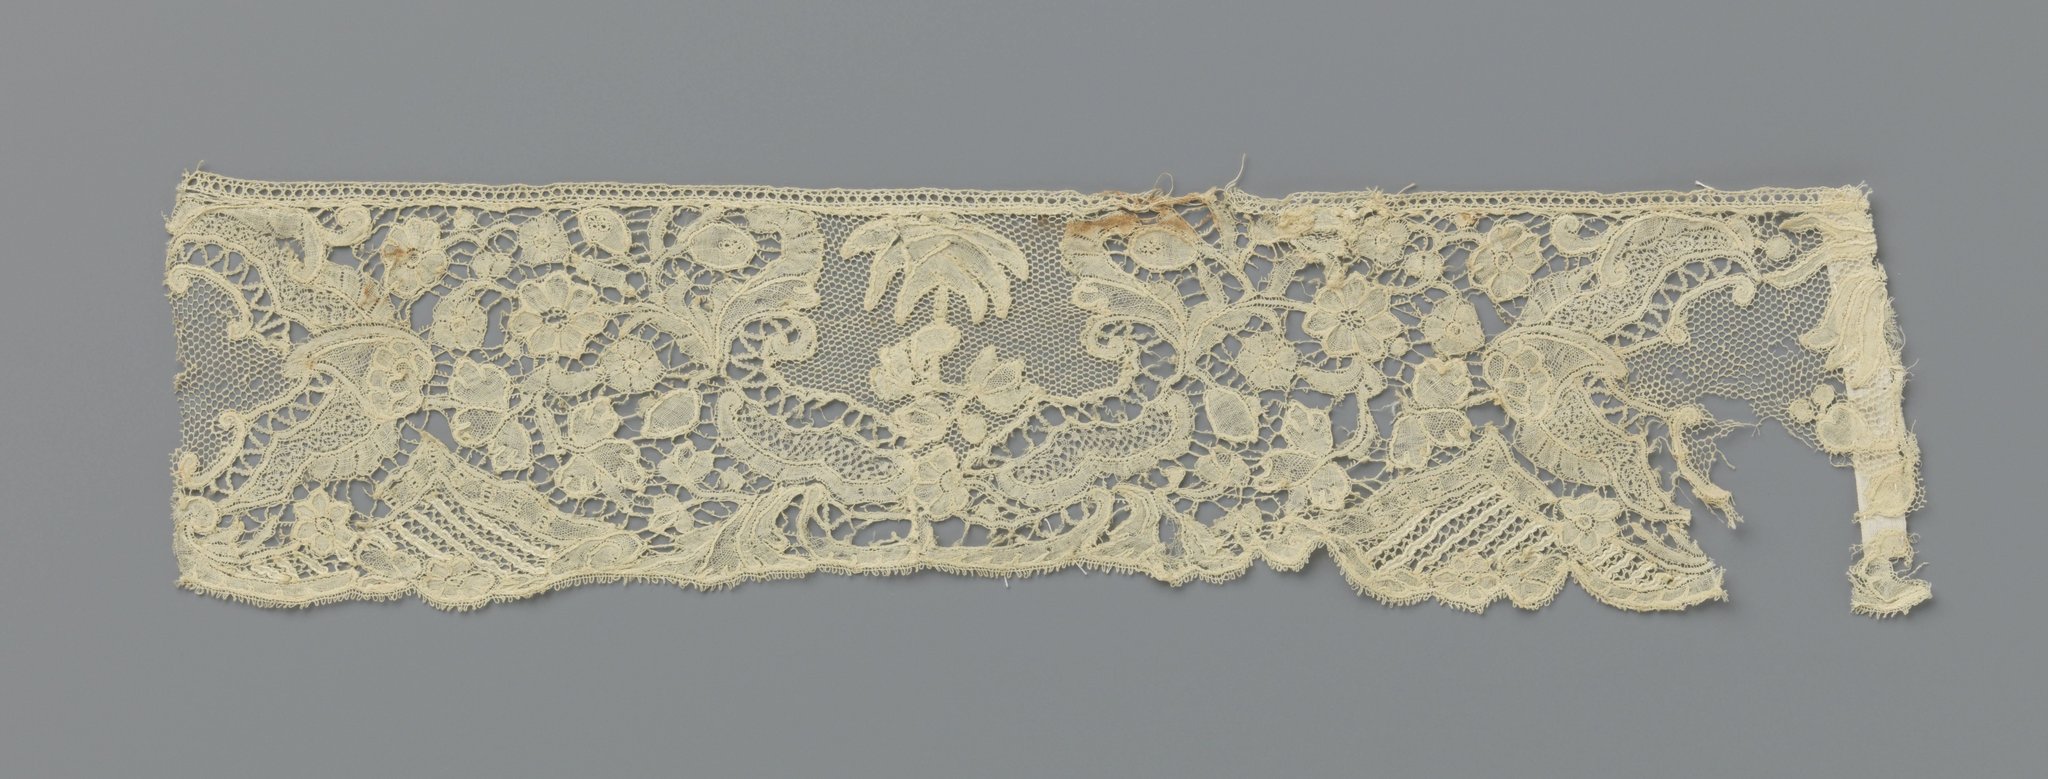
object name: strip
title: Strook kloskant met palmboom-achtige applicatie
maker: Anonymous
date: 1725-1749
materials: linen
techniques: lace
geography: brussels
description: Strook naturelkleurige Brusselse kloskant. Het symmetrische patroon bestaat in het midden uit een cartouche in de vorm van een wapenschild, gevormd door omkrullende bladeren en voluten. In de cartouche is een palmboom-achtig motief geappliceerd. Het schild wordt geflankeerd door verschillende bloempjes, die door gepicoteerde vlechten met elkaar zijn verbonden. Aan de korte kanten is de helft van een gelobd cartouche te zien. De velden in alle cartouches bestaan uit een fijne maasgrond, een drochelgrond. Het volwerk is grotendeels gemaakt in linnenslag met opengewerkte randjes en enkele uitsparingen en deels in netslag. De meeste motieven hebben gekloste reliëfcontouren. Siergronden, waaronder een sneeuwvlokkengrond, is toegepast in de lijsten om de cartouches en in een driehoekig veld langs de onderzijde is een siergrond te zien met schuine strepen. De bovenzijde is afgewerkt met een apart geklost bandje. De geschulpte onderzijde is afgewerkt met picots.